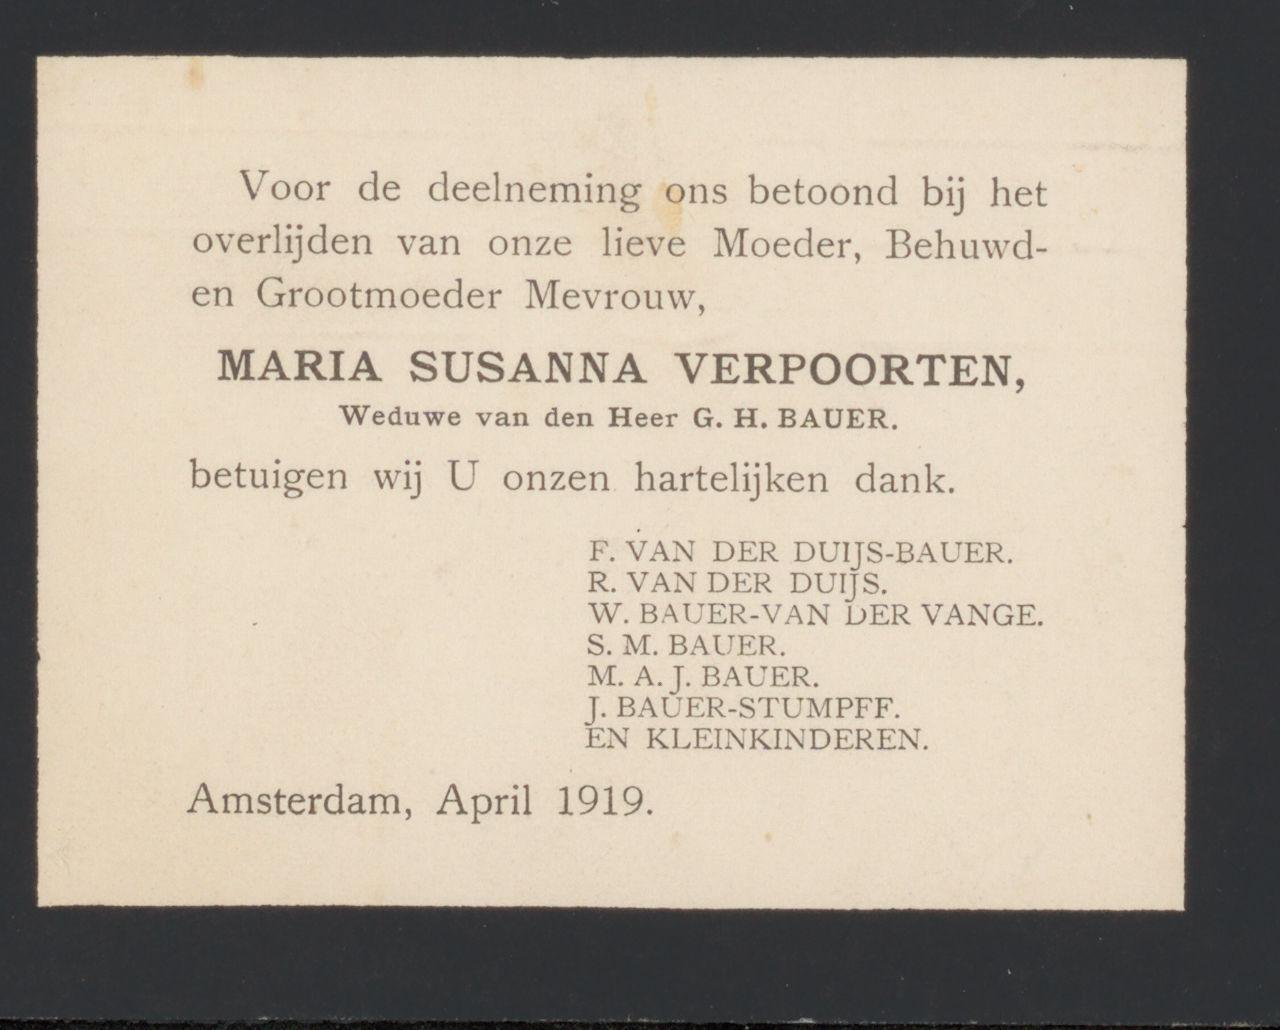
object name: bedankkaart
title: Bedankkaart aan Philip Zilcken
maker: Anonymous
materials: cardboard, ink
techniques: pen, printing, writing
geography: amsterdam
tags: painter, draughtsman, philip zilcken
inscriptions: collector's mark: ‘RPK’